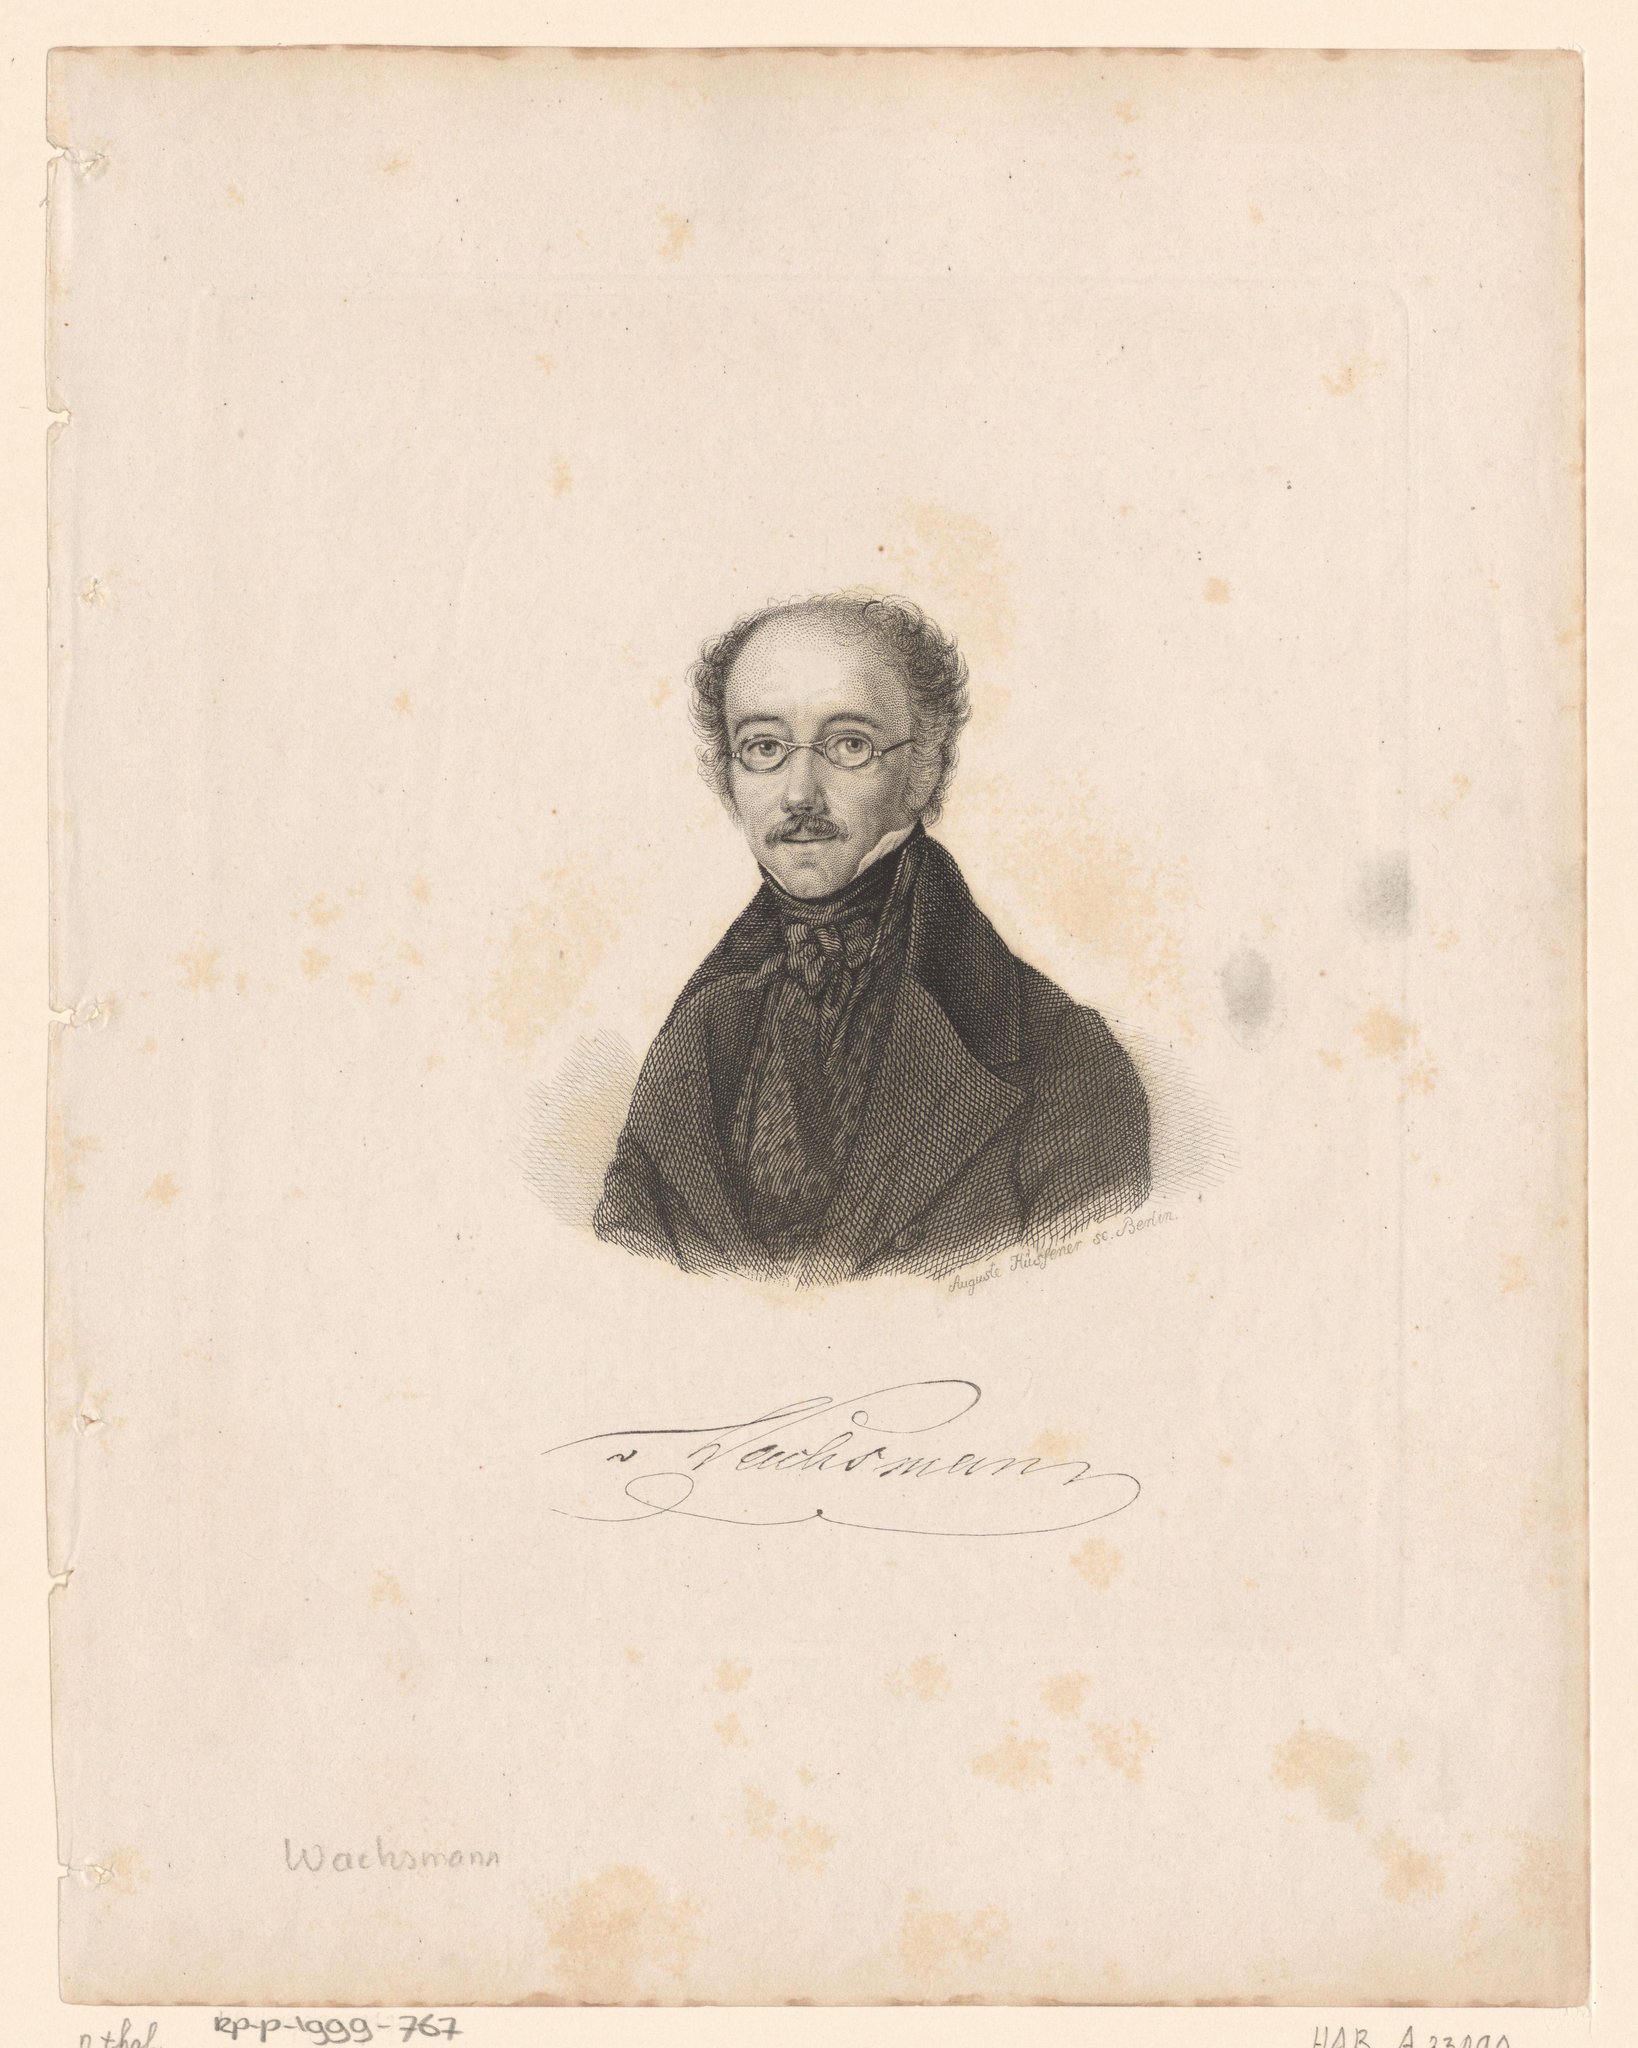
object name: print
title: Portret Carl Adolph von Wachsmann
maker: auguste hüssener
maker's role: print maker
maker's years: 1789-1877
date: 1817-1877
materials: paper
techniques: etching, roulette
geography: berlin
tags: historical persons, portrait of a writer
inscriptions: collector's mark: Lugt 2228